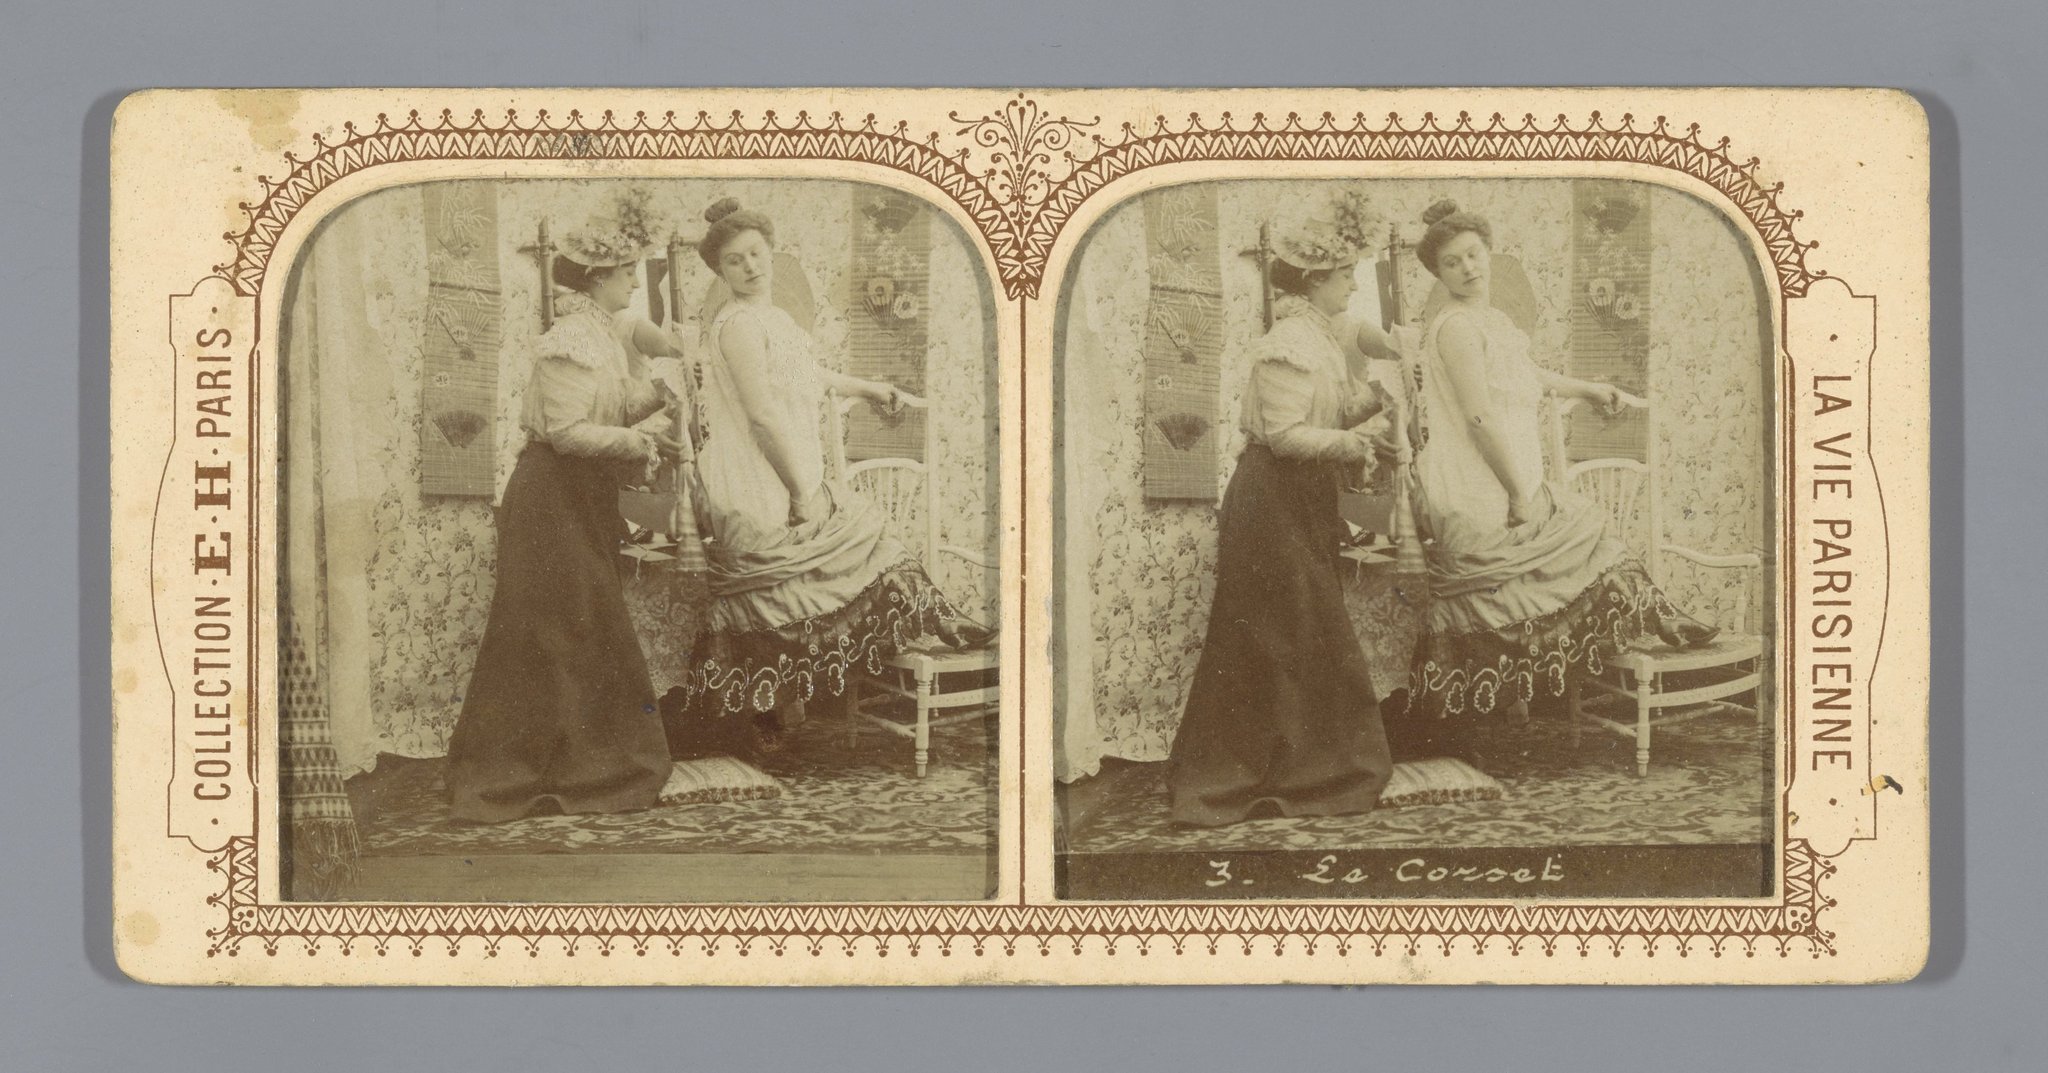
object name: tissue stereograph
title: La vie Parisienne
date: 1880-1905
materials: cardboard, paper, photographic support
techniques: albumen print, hand coloring, perforating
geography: paris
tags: dressing someone else - aa - female human figure, paris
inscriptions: number: ‘3’